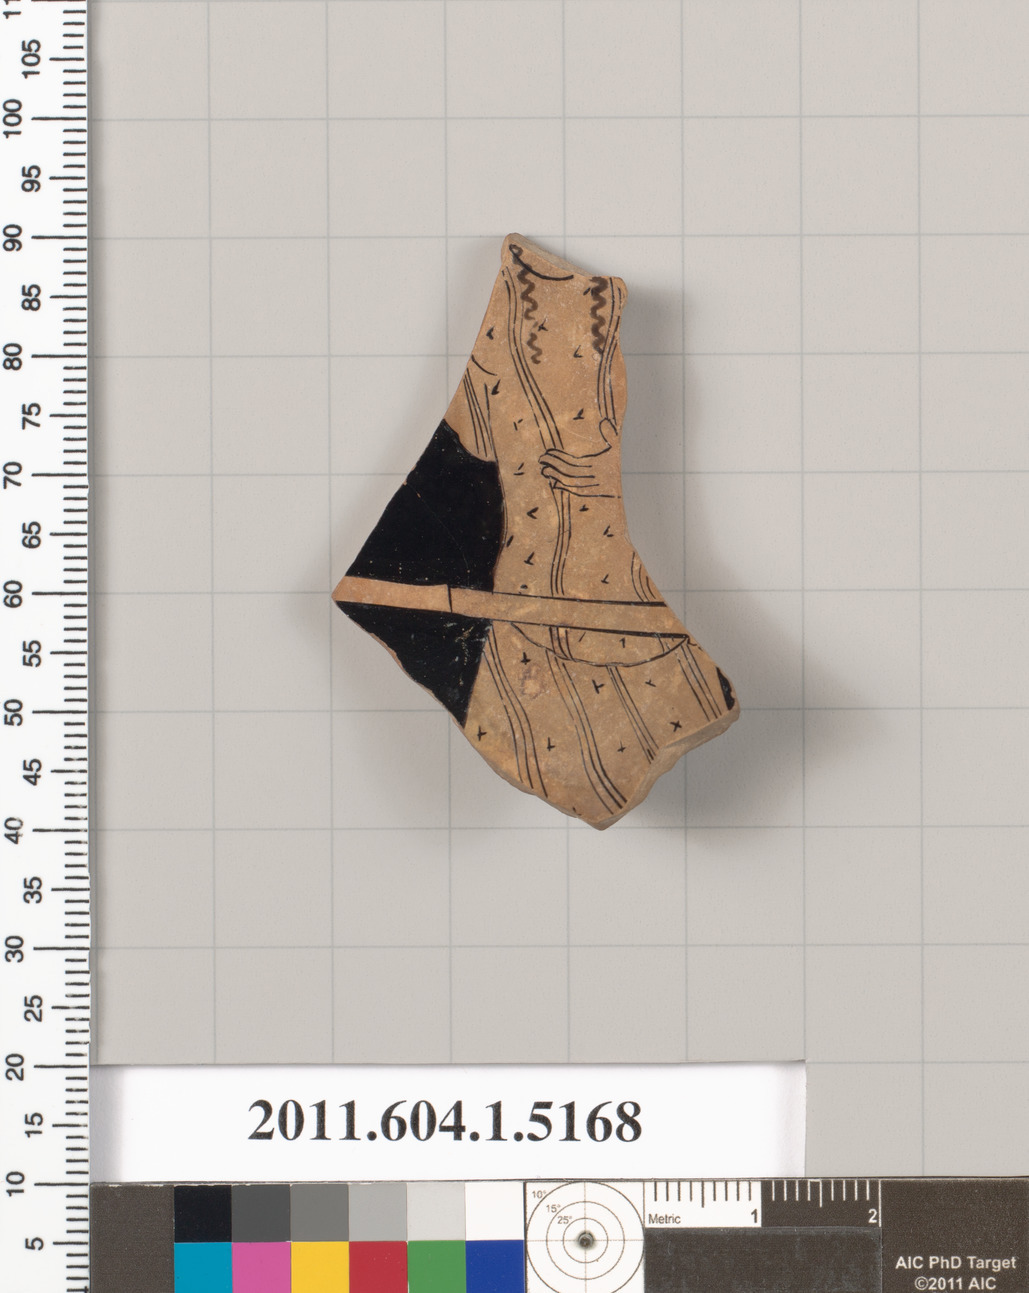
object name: kylix fragment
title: Terracotta fragment of a kylix (drinking cup)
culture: greek, attic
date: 500-480 BCE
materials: terracotta